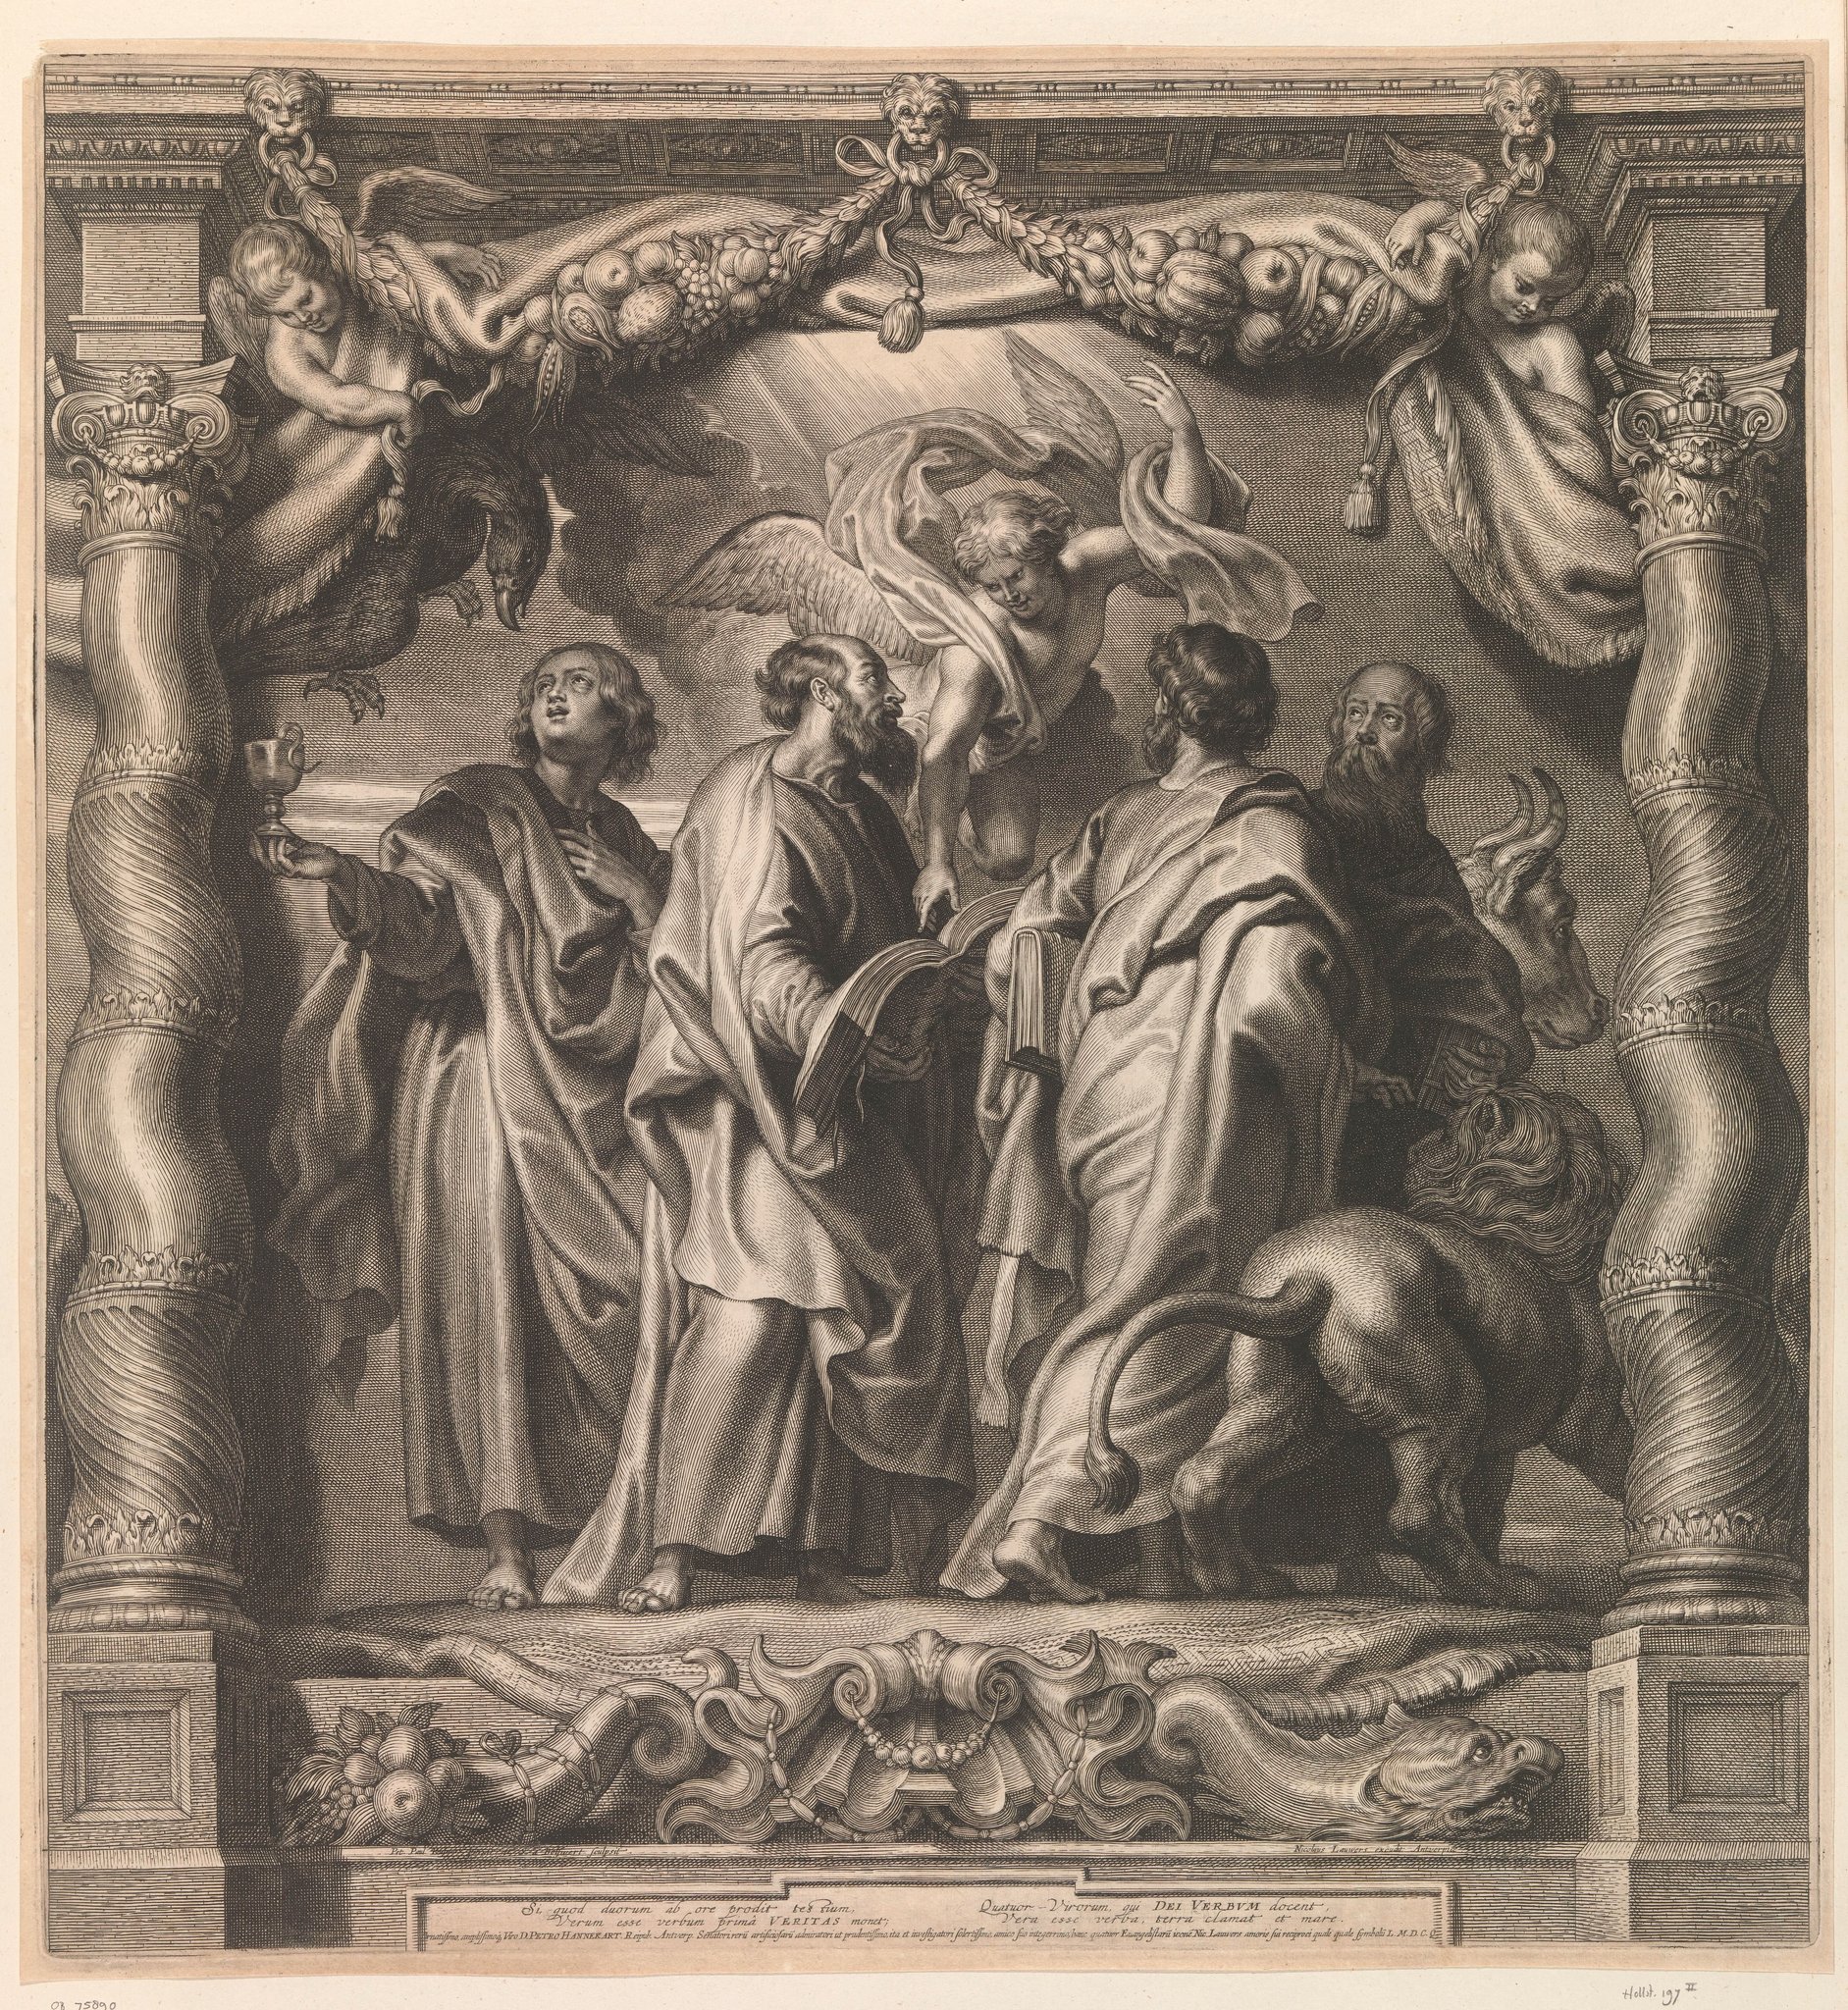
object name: print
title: Vier evangelisten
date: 1596-1659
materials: paper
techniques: engraving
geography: southern netherlands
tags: the apostle john the evangelist; possible attributes: book, cauldron, chalice with snake, eagle, palm, scroll, luke the evangelist; possible attributes: book, (winged) ox, portrait of the virgin, surgical instruments, painter's utensils, scroll, the apostle and evangelist matthew (mattheus); possible attributes: angel, axe, book, halberd, pen and inkhorn, purse, scroll, square, sword, mark (marcus) the evangelist, and bishop of alexandria; possible attributes: book, (winged) lion, pen and inkhorn, scroll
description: Vier evangelisten met hun attributen in architecturale setting. In een cartouche staat een Latijns vers van vier regels. Deze prent maakt deel uit van een album.